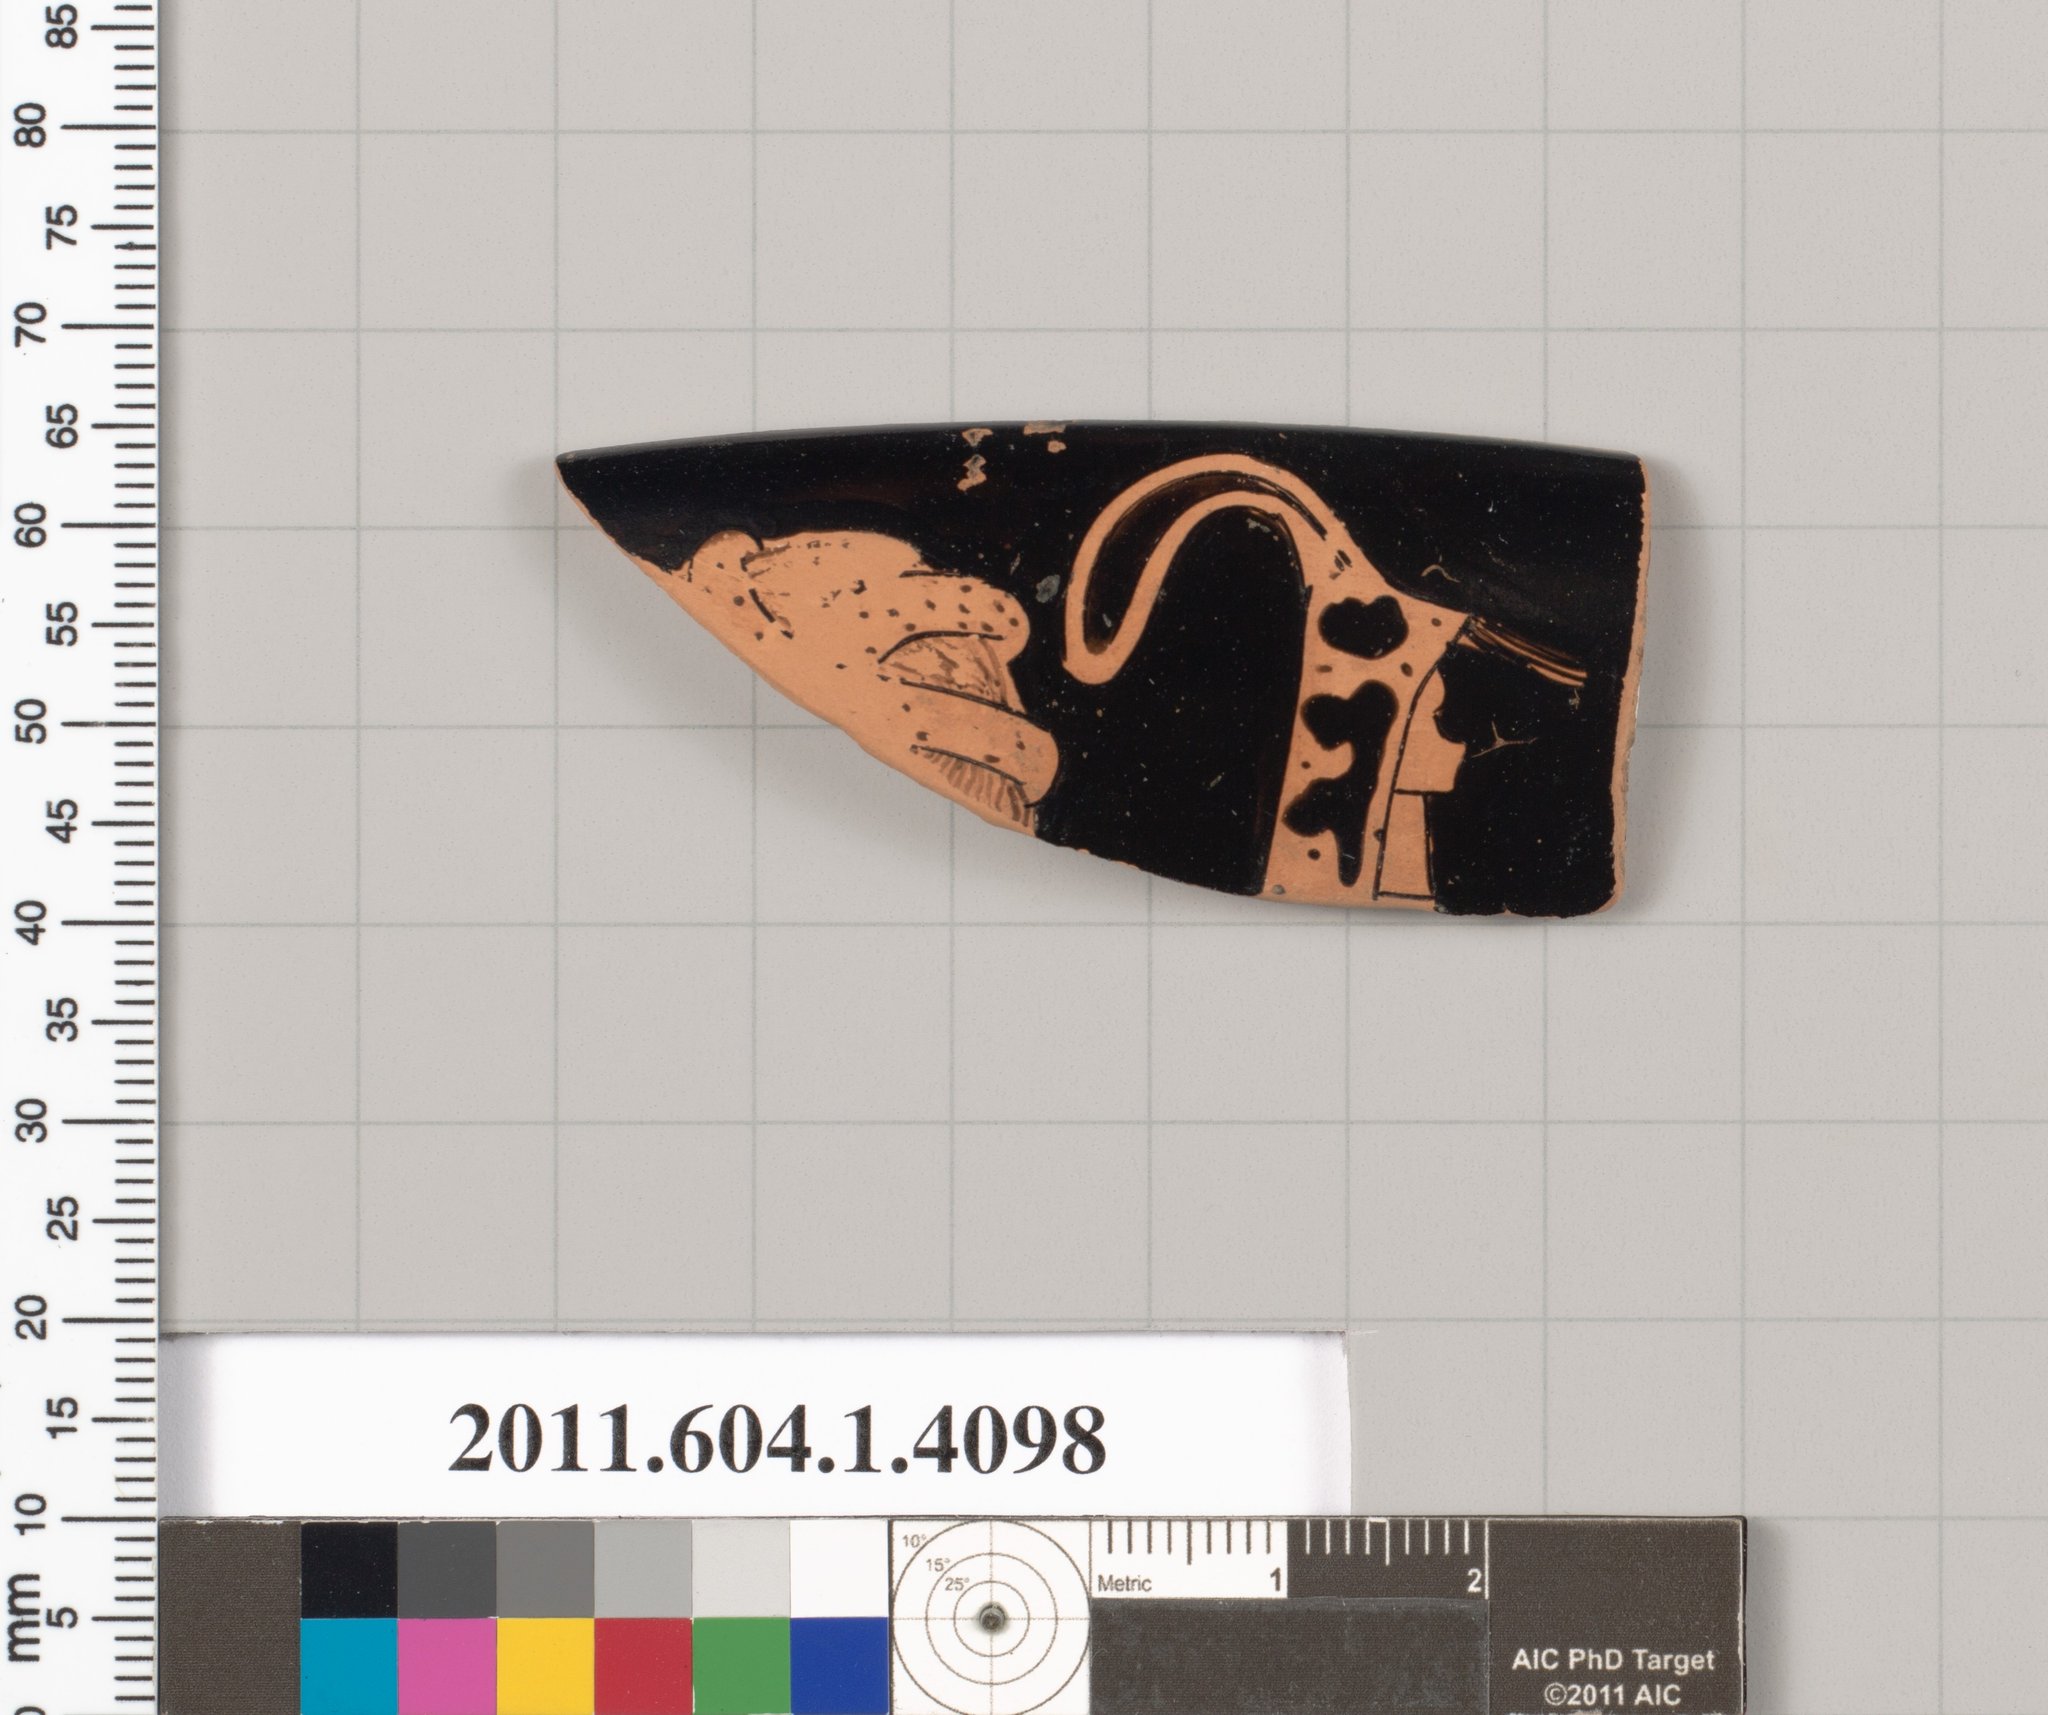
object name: kylix fragment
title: Terracotta rim fragment of a kylix (drinking cup)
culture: greek, attic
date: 500-480 BCE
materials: terracotta